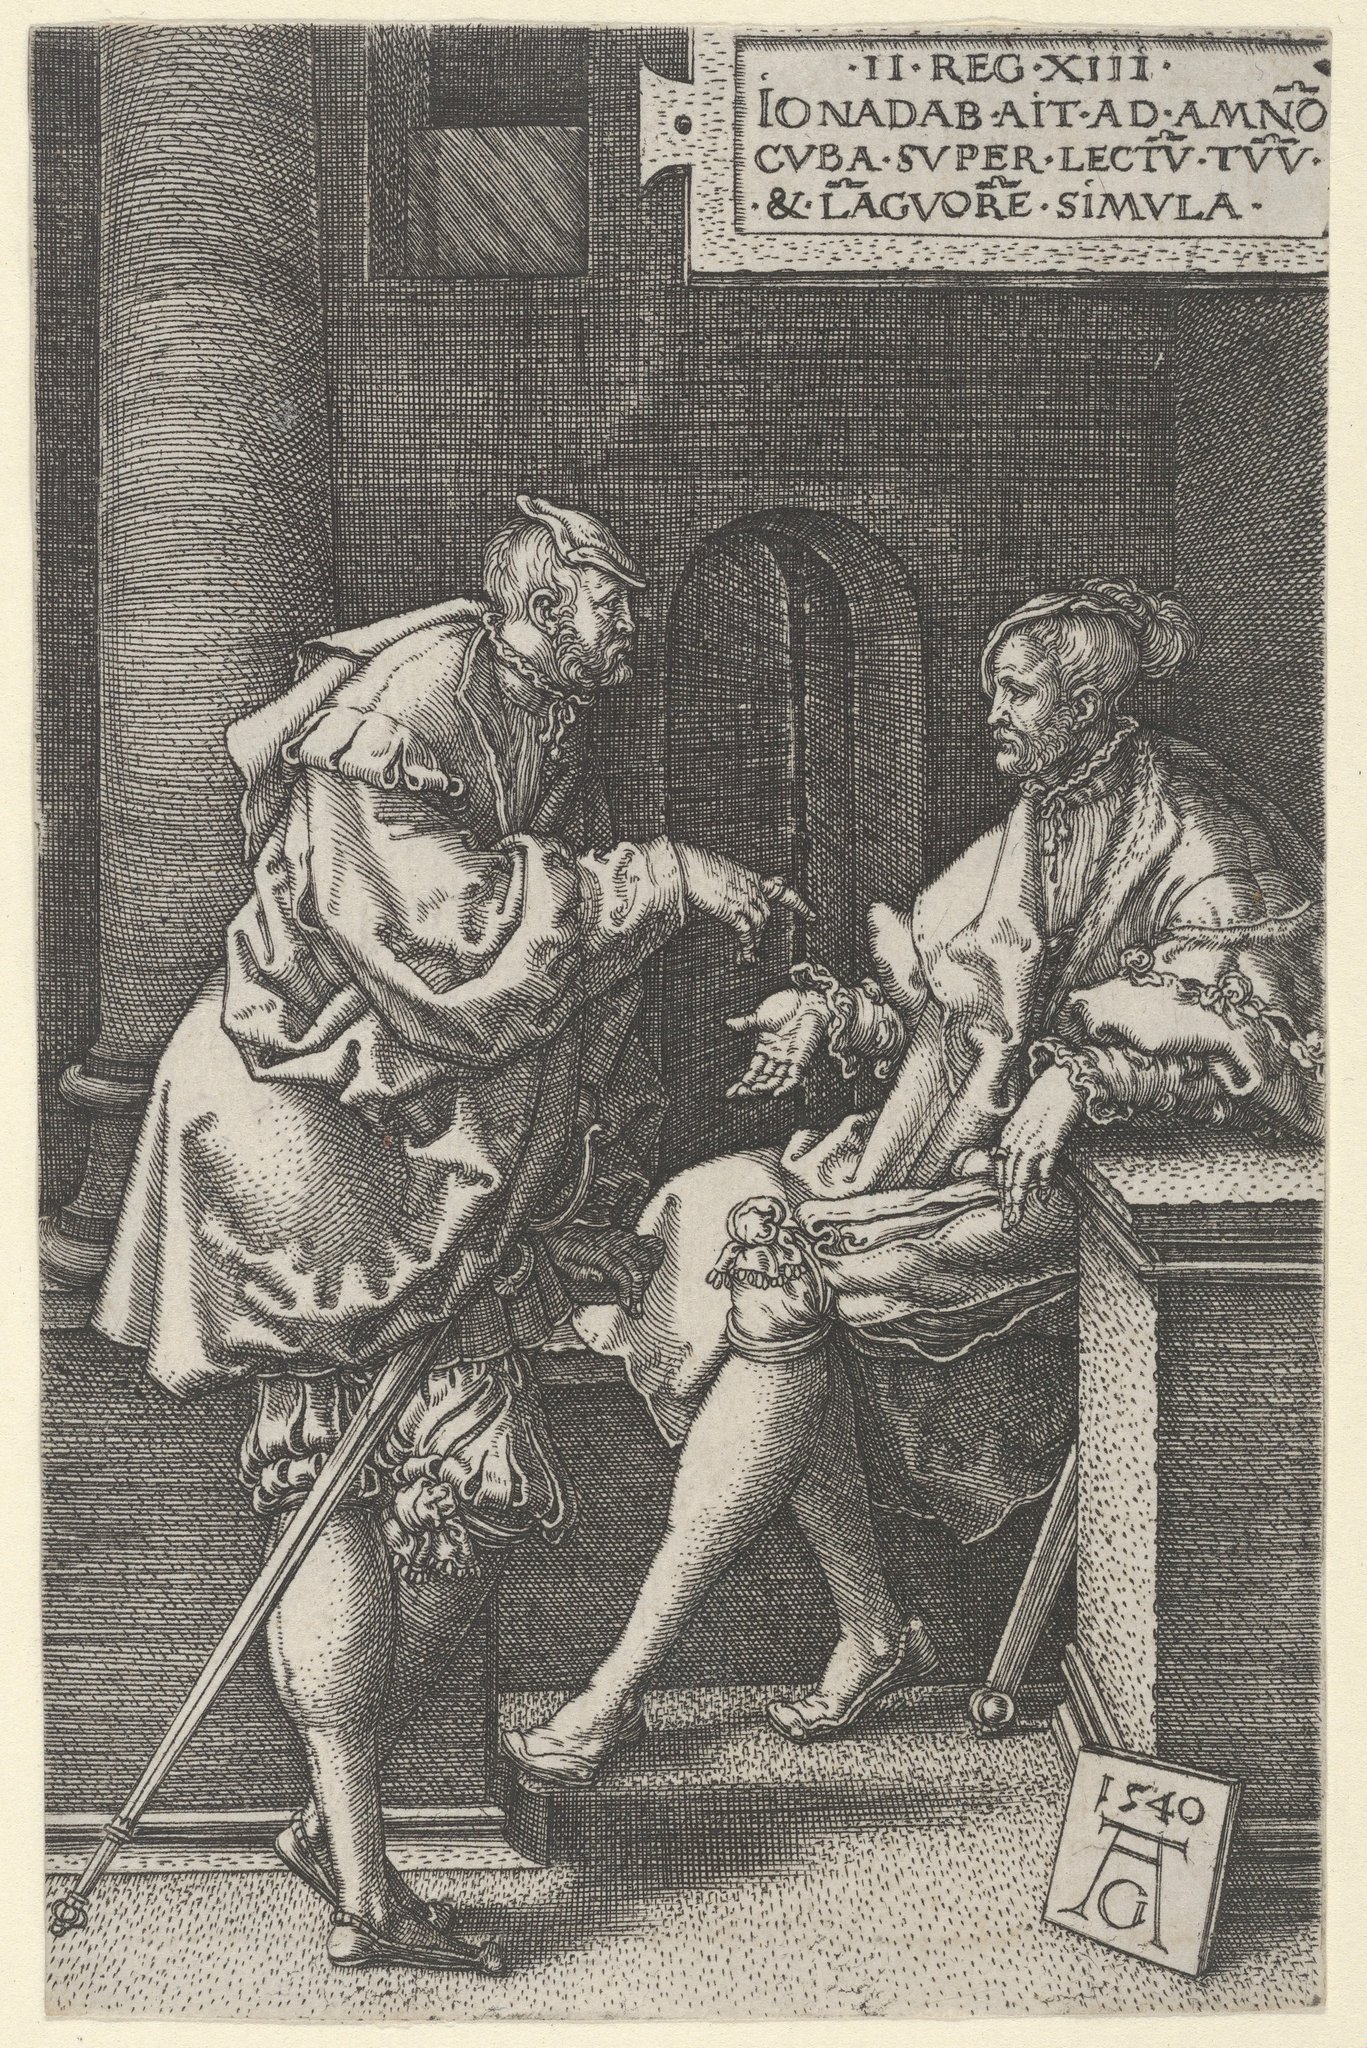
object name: print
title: Amnon and Jonadab, from "The Story of Amnon and Tamar"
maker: heinrich aldegrever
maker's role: artist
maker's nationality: german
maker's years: 1502-1561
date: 1540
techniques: engraving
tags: men